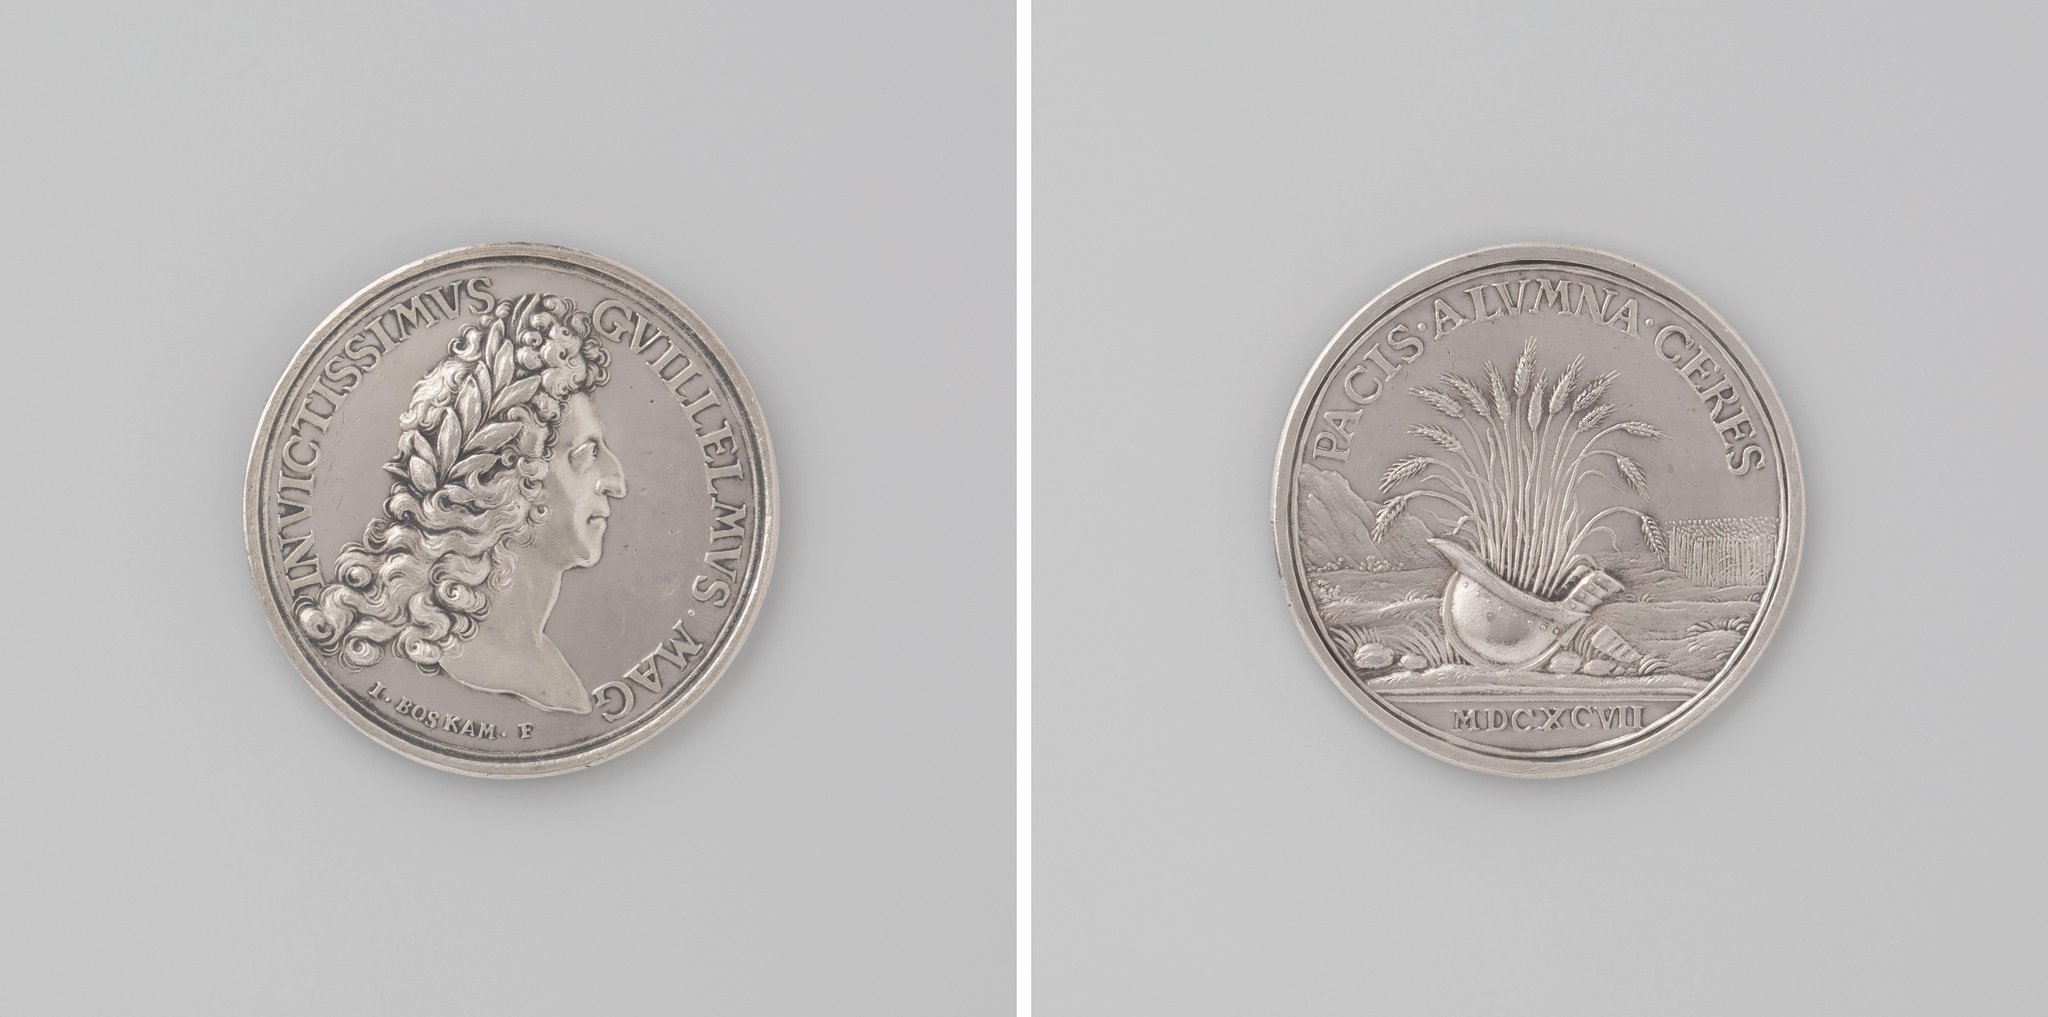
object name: history medal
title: Vrede van Rijswijk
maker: jan boskam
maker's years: 1687-1708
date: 1697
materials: silver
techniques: striking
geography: nijmegen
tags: the hague, william iii (prince of orange and king of england, scotland, and ireland)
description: Zilveren penning. Voorzijde: borststuk man met lauwerkrans binnen omschrift. Keerzijde: korenhalmen groeiend uit helm binnen omschrift; afsnede: jaartal